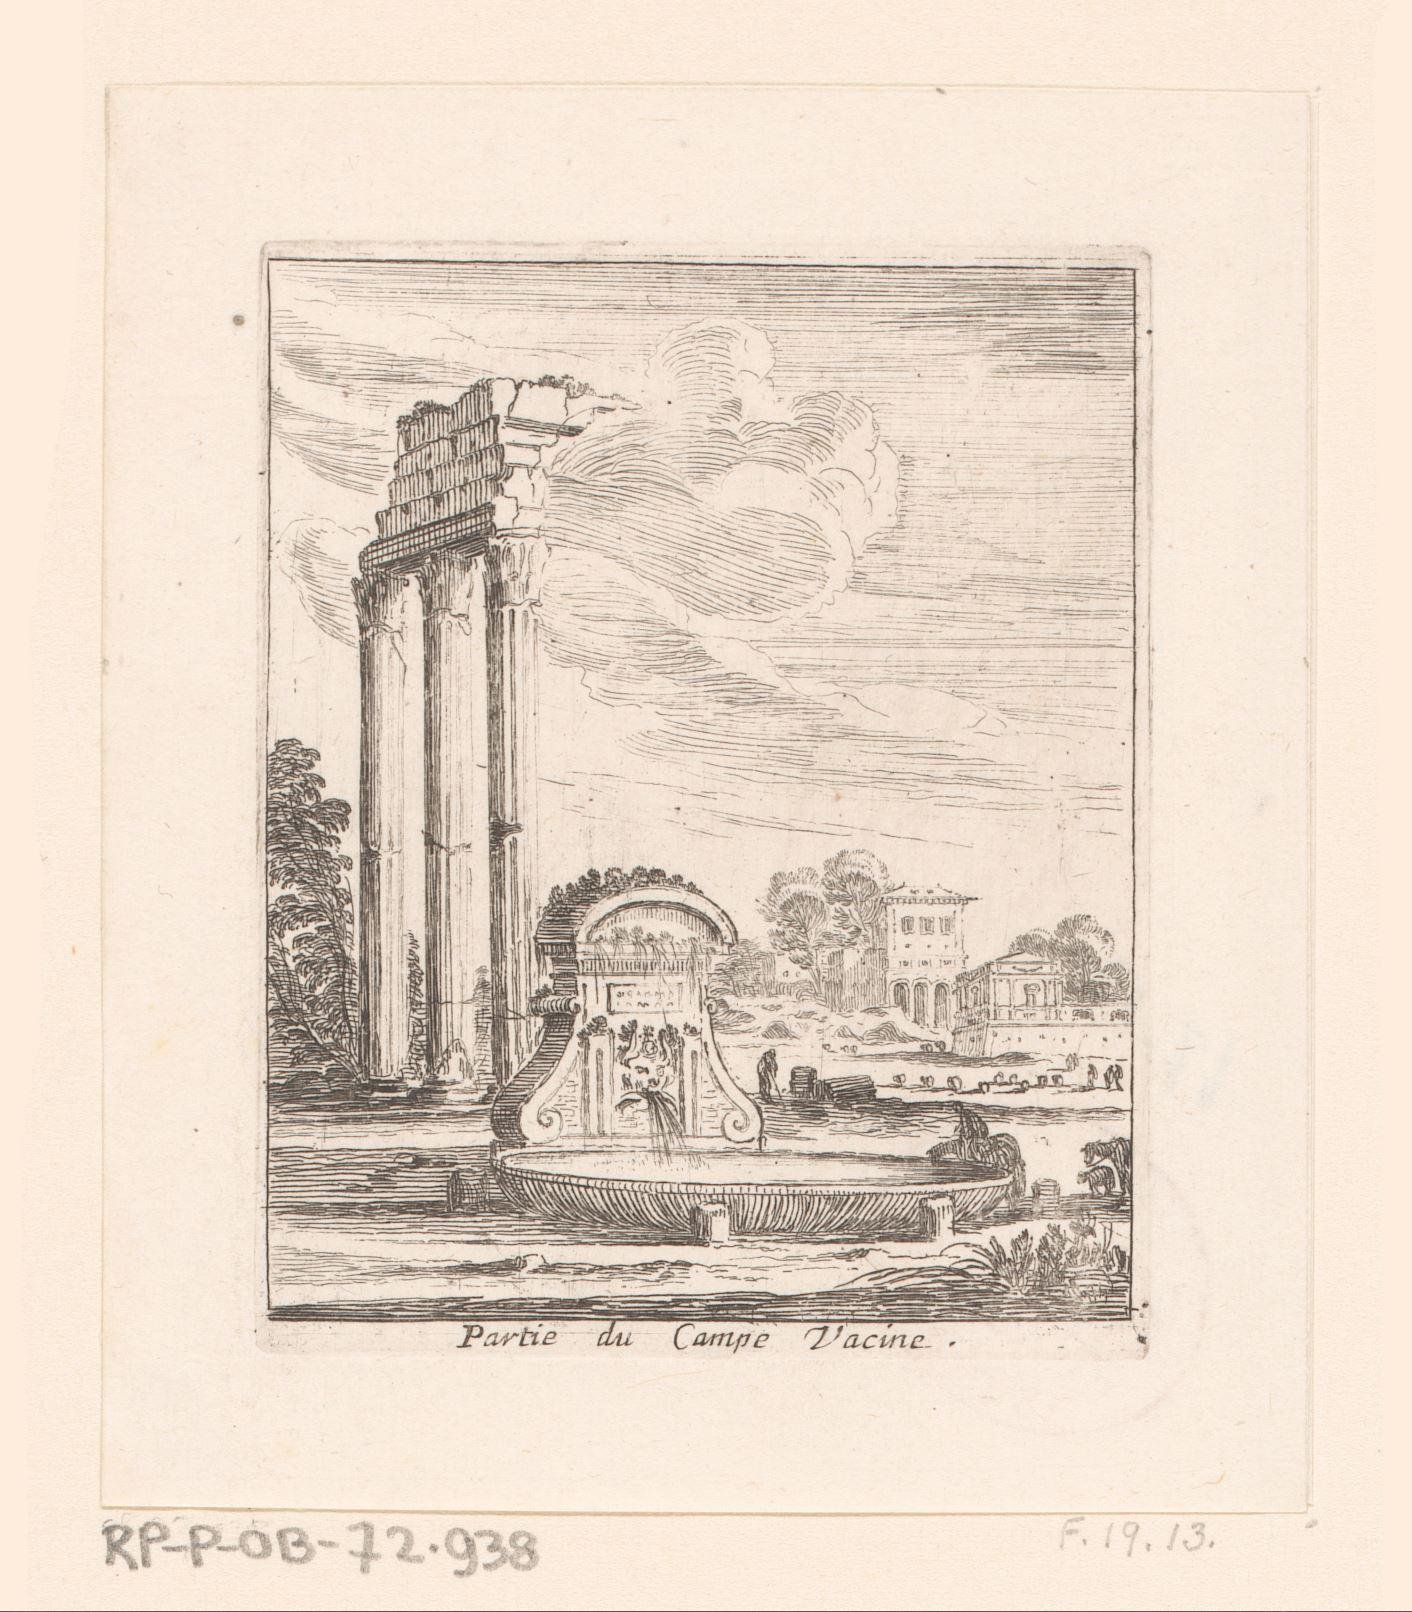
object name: print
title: Diverse gezichten op Italië en andere plaatsen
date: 1631-1661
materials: paper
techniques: etching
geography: france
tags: landscape with ruins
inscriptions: collector's mark: Lugt 240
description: Prent maakt deel uit van een ongenummerde serie van 22 prenten.